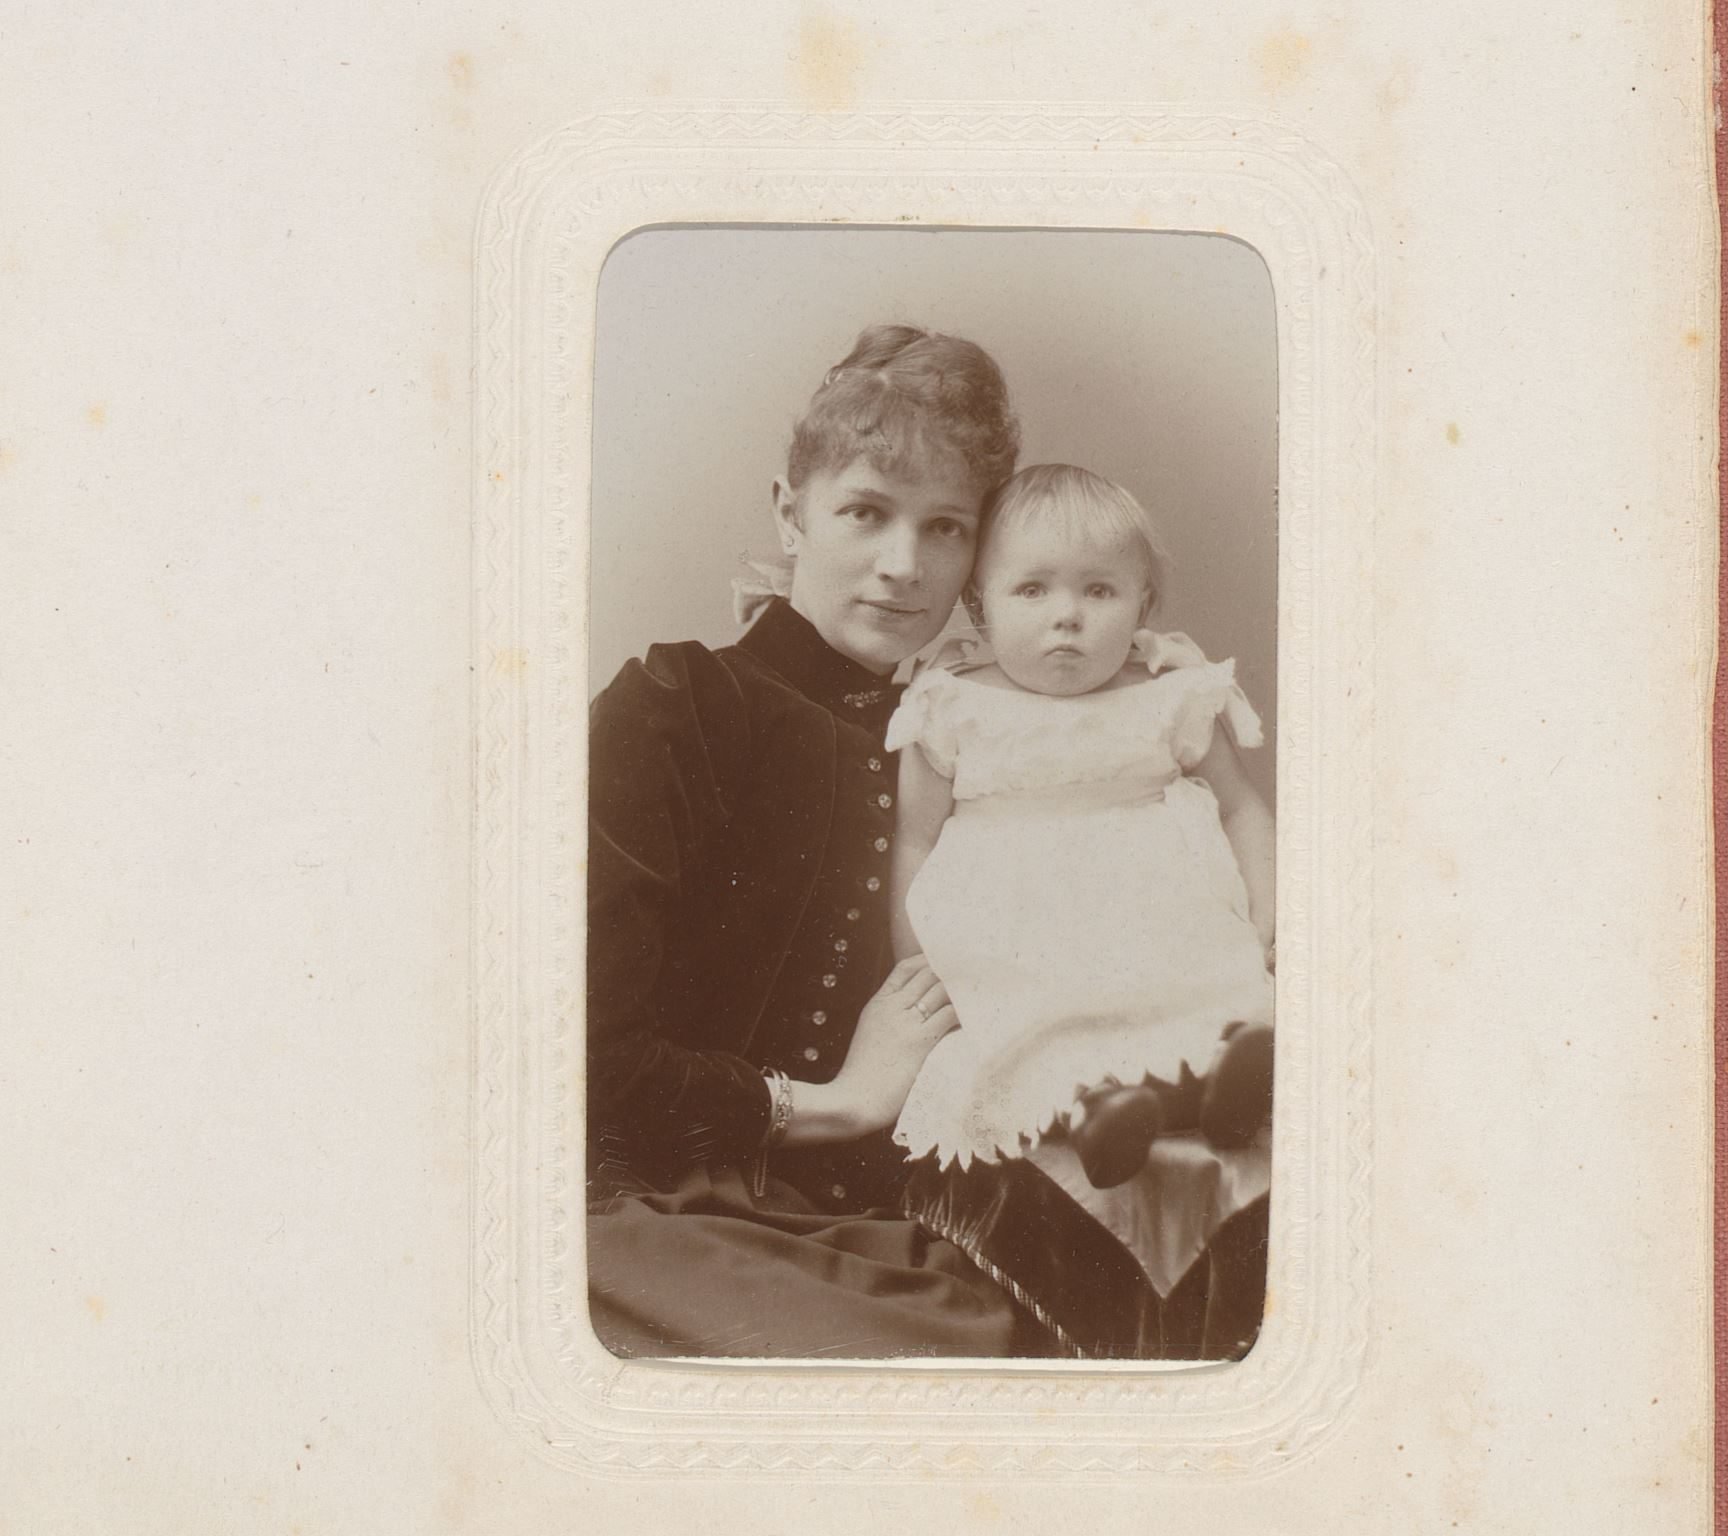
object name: album leaf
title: Portret van een vrouw met een meisje op schoot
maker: carl freund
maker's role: fotograaf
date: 1893-1894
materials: cardboard, photographic support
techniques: collodion silver print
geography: elberfeld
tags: historical persons - bb - woman, toddler (female)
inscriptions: inscription: ‘Carl Freund/ Elberfeld/ Hofauer-Strasse 80./ Platten werden zu Nachbestellungen aufbewahrt./ Vergrösserungen nach diesem Bilde können in jedem/ (...)’